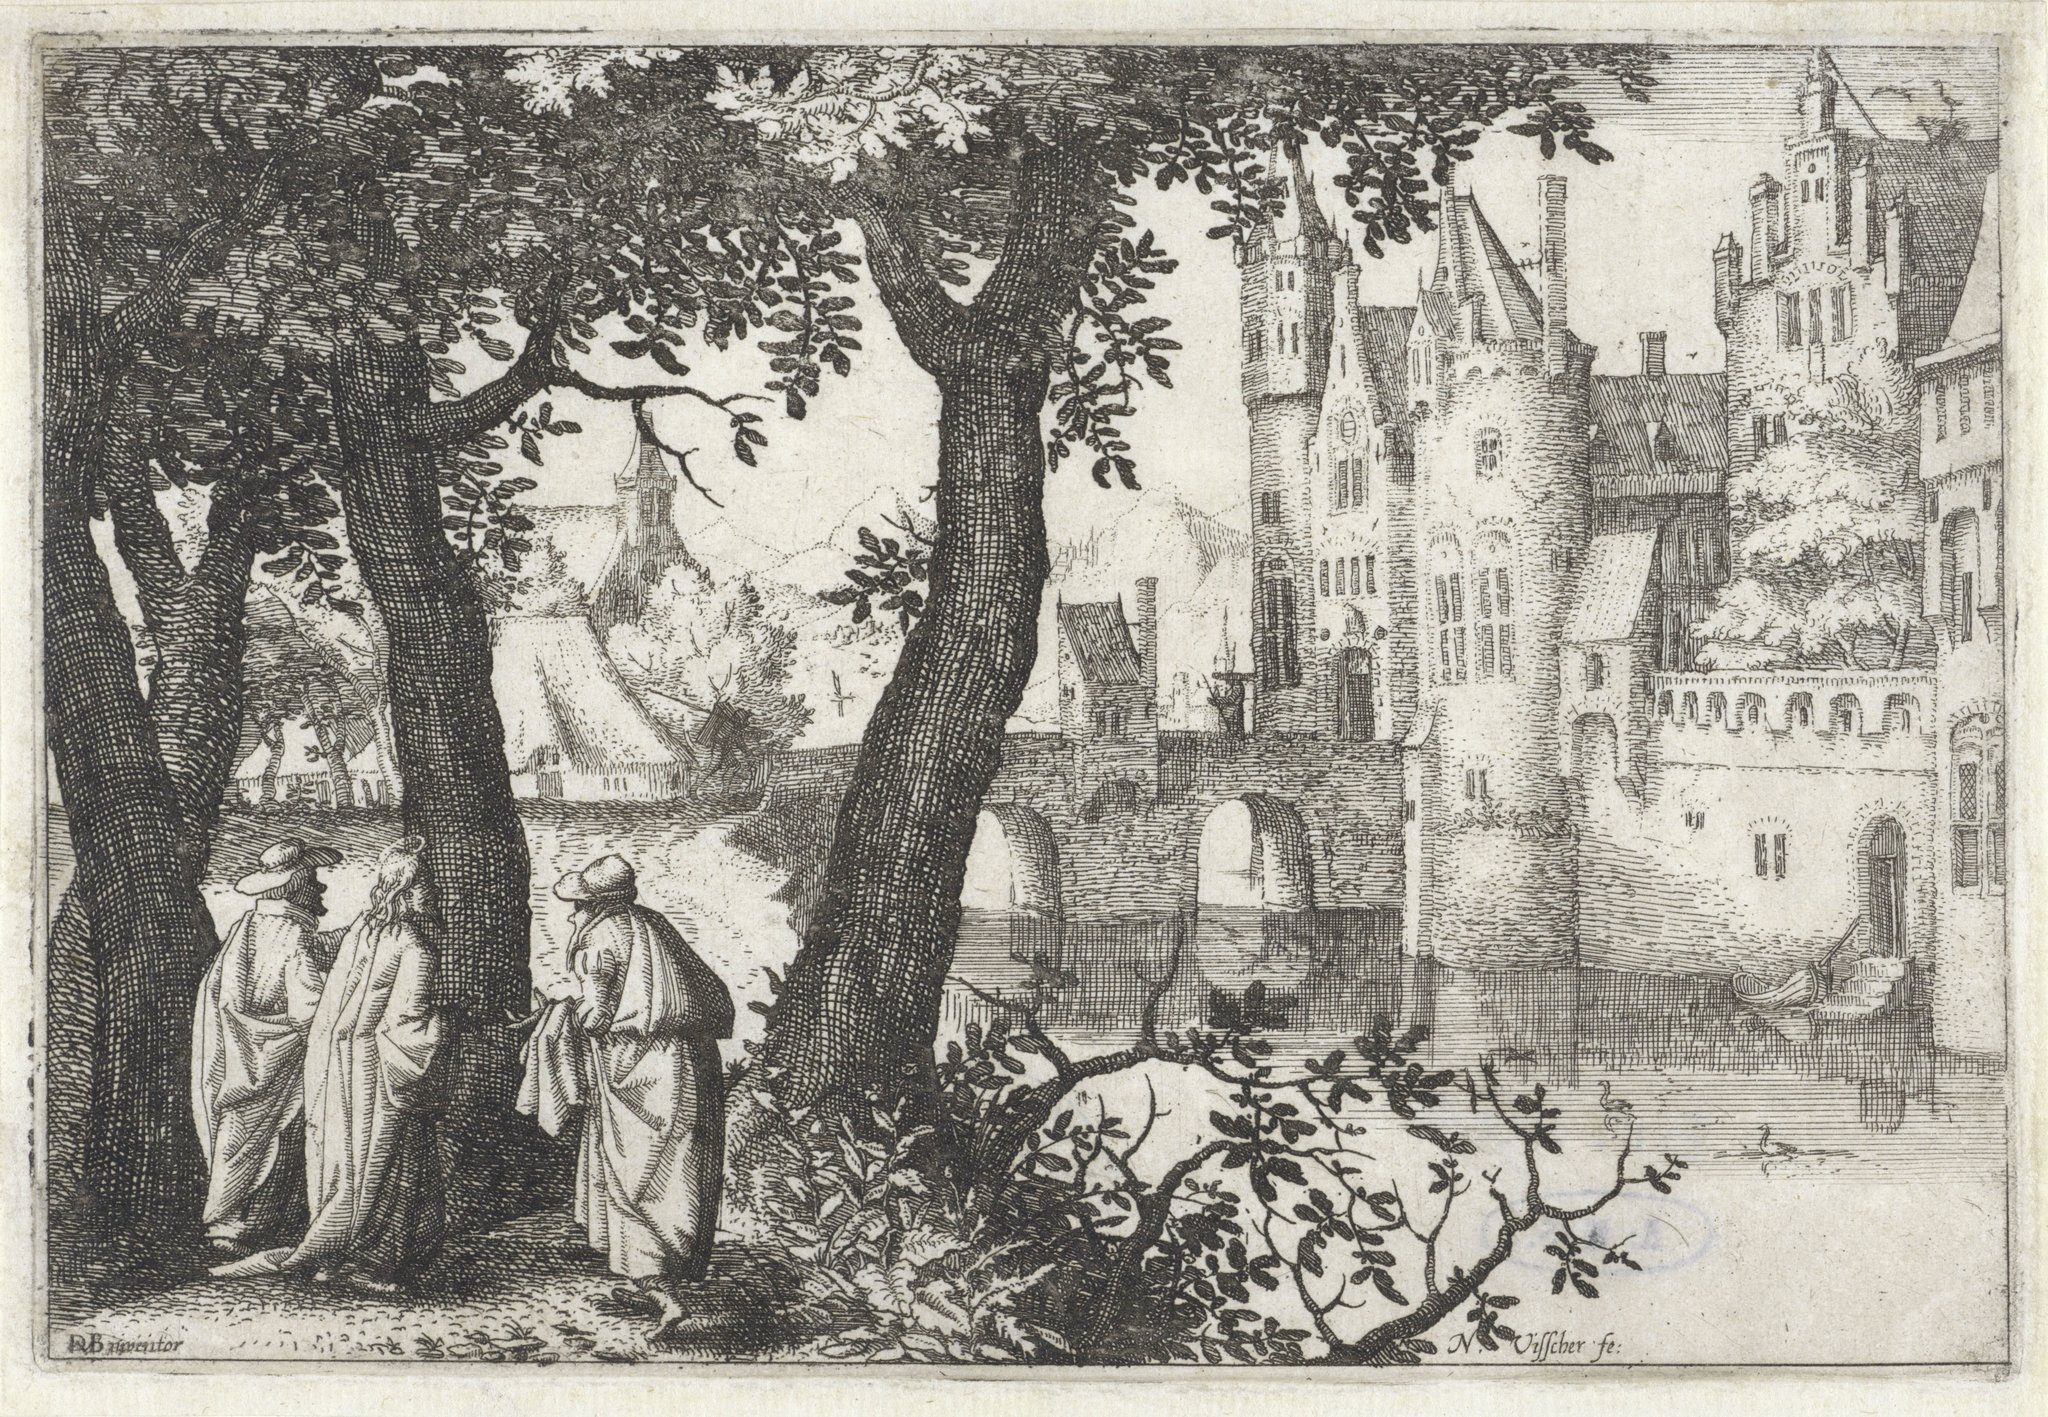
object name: print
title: Landschap met de Emmaüsgangers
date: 1596-1630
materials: paper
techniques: etching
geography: amsterdam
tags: cleopas and peter arrive at the gate of emmaus, or at the inn; christ is asked to stay, city-walls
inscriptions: monogram: ‘DvB inventor’ Lugt, signature: ‘N. Visscher fe.’, collector's mark: 2228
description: Christus en twee van zijn disciplelen op weg naar Emmaus. Zij lopen, links op de voorgrond, tussen de bomen. Rechts een ommuurde stad met stadspoort en stadsgracht te zien.